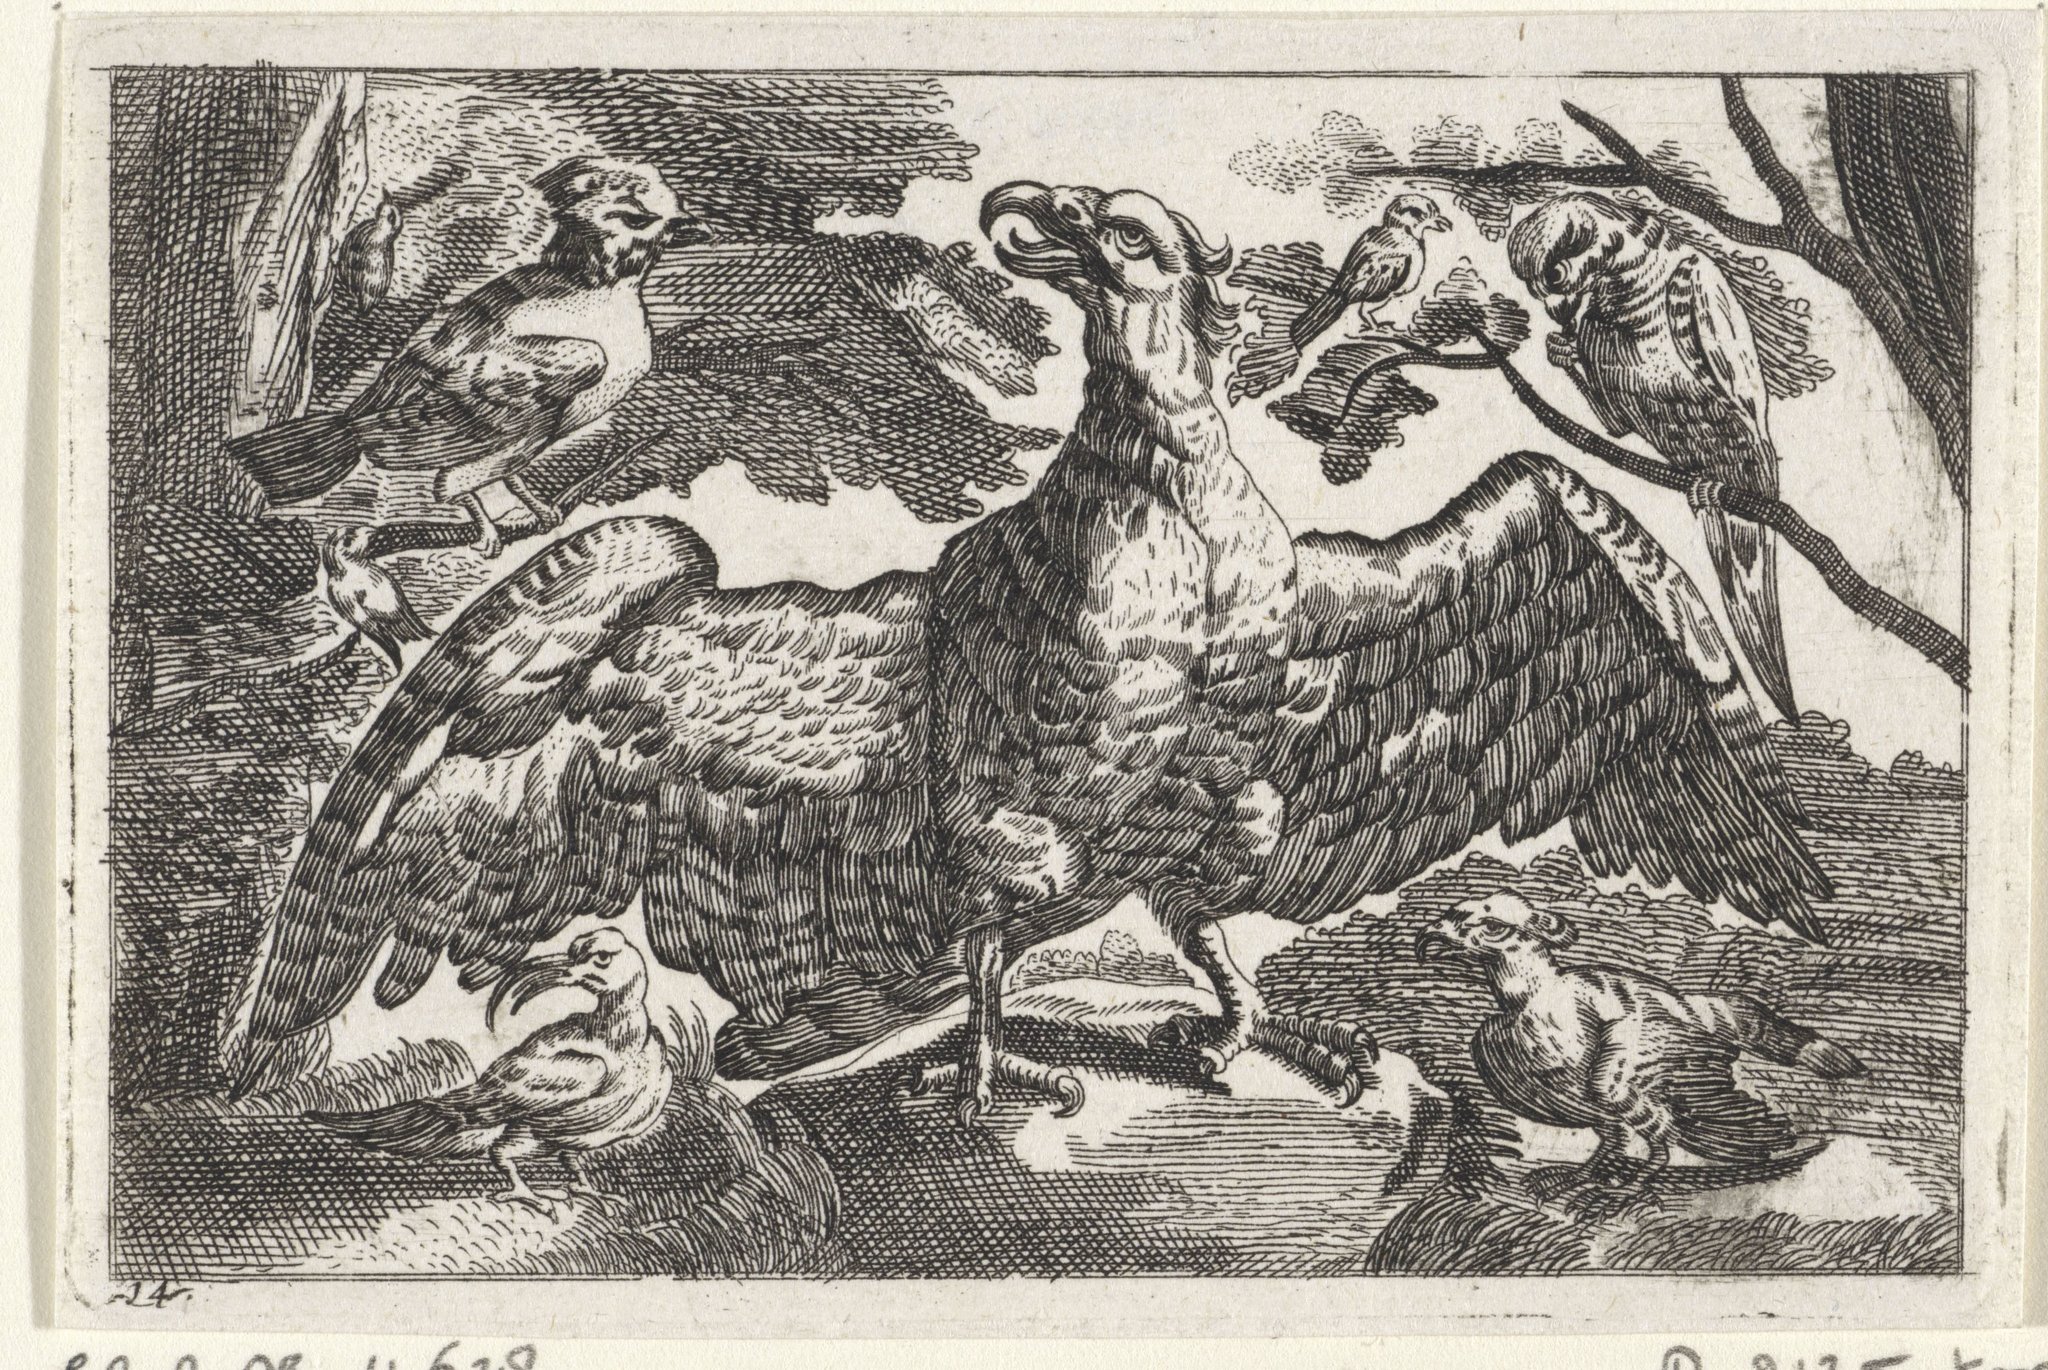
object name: print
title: Arend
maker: Anonymous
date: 1654-1712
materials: paper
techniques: etching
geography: england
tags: predatory birds: eagle, birds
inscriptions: collector's mark: Lugt 240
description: Verkleinde kopie naar prent uit de serie "Verschillende vogels" door Wenceslaus Hollar.